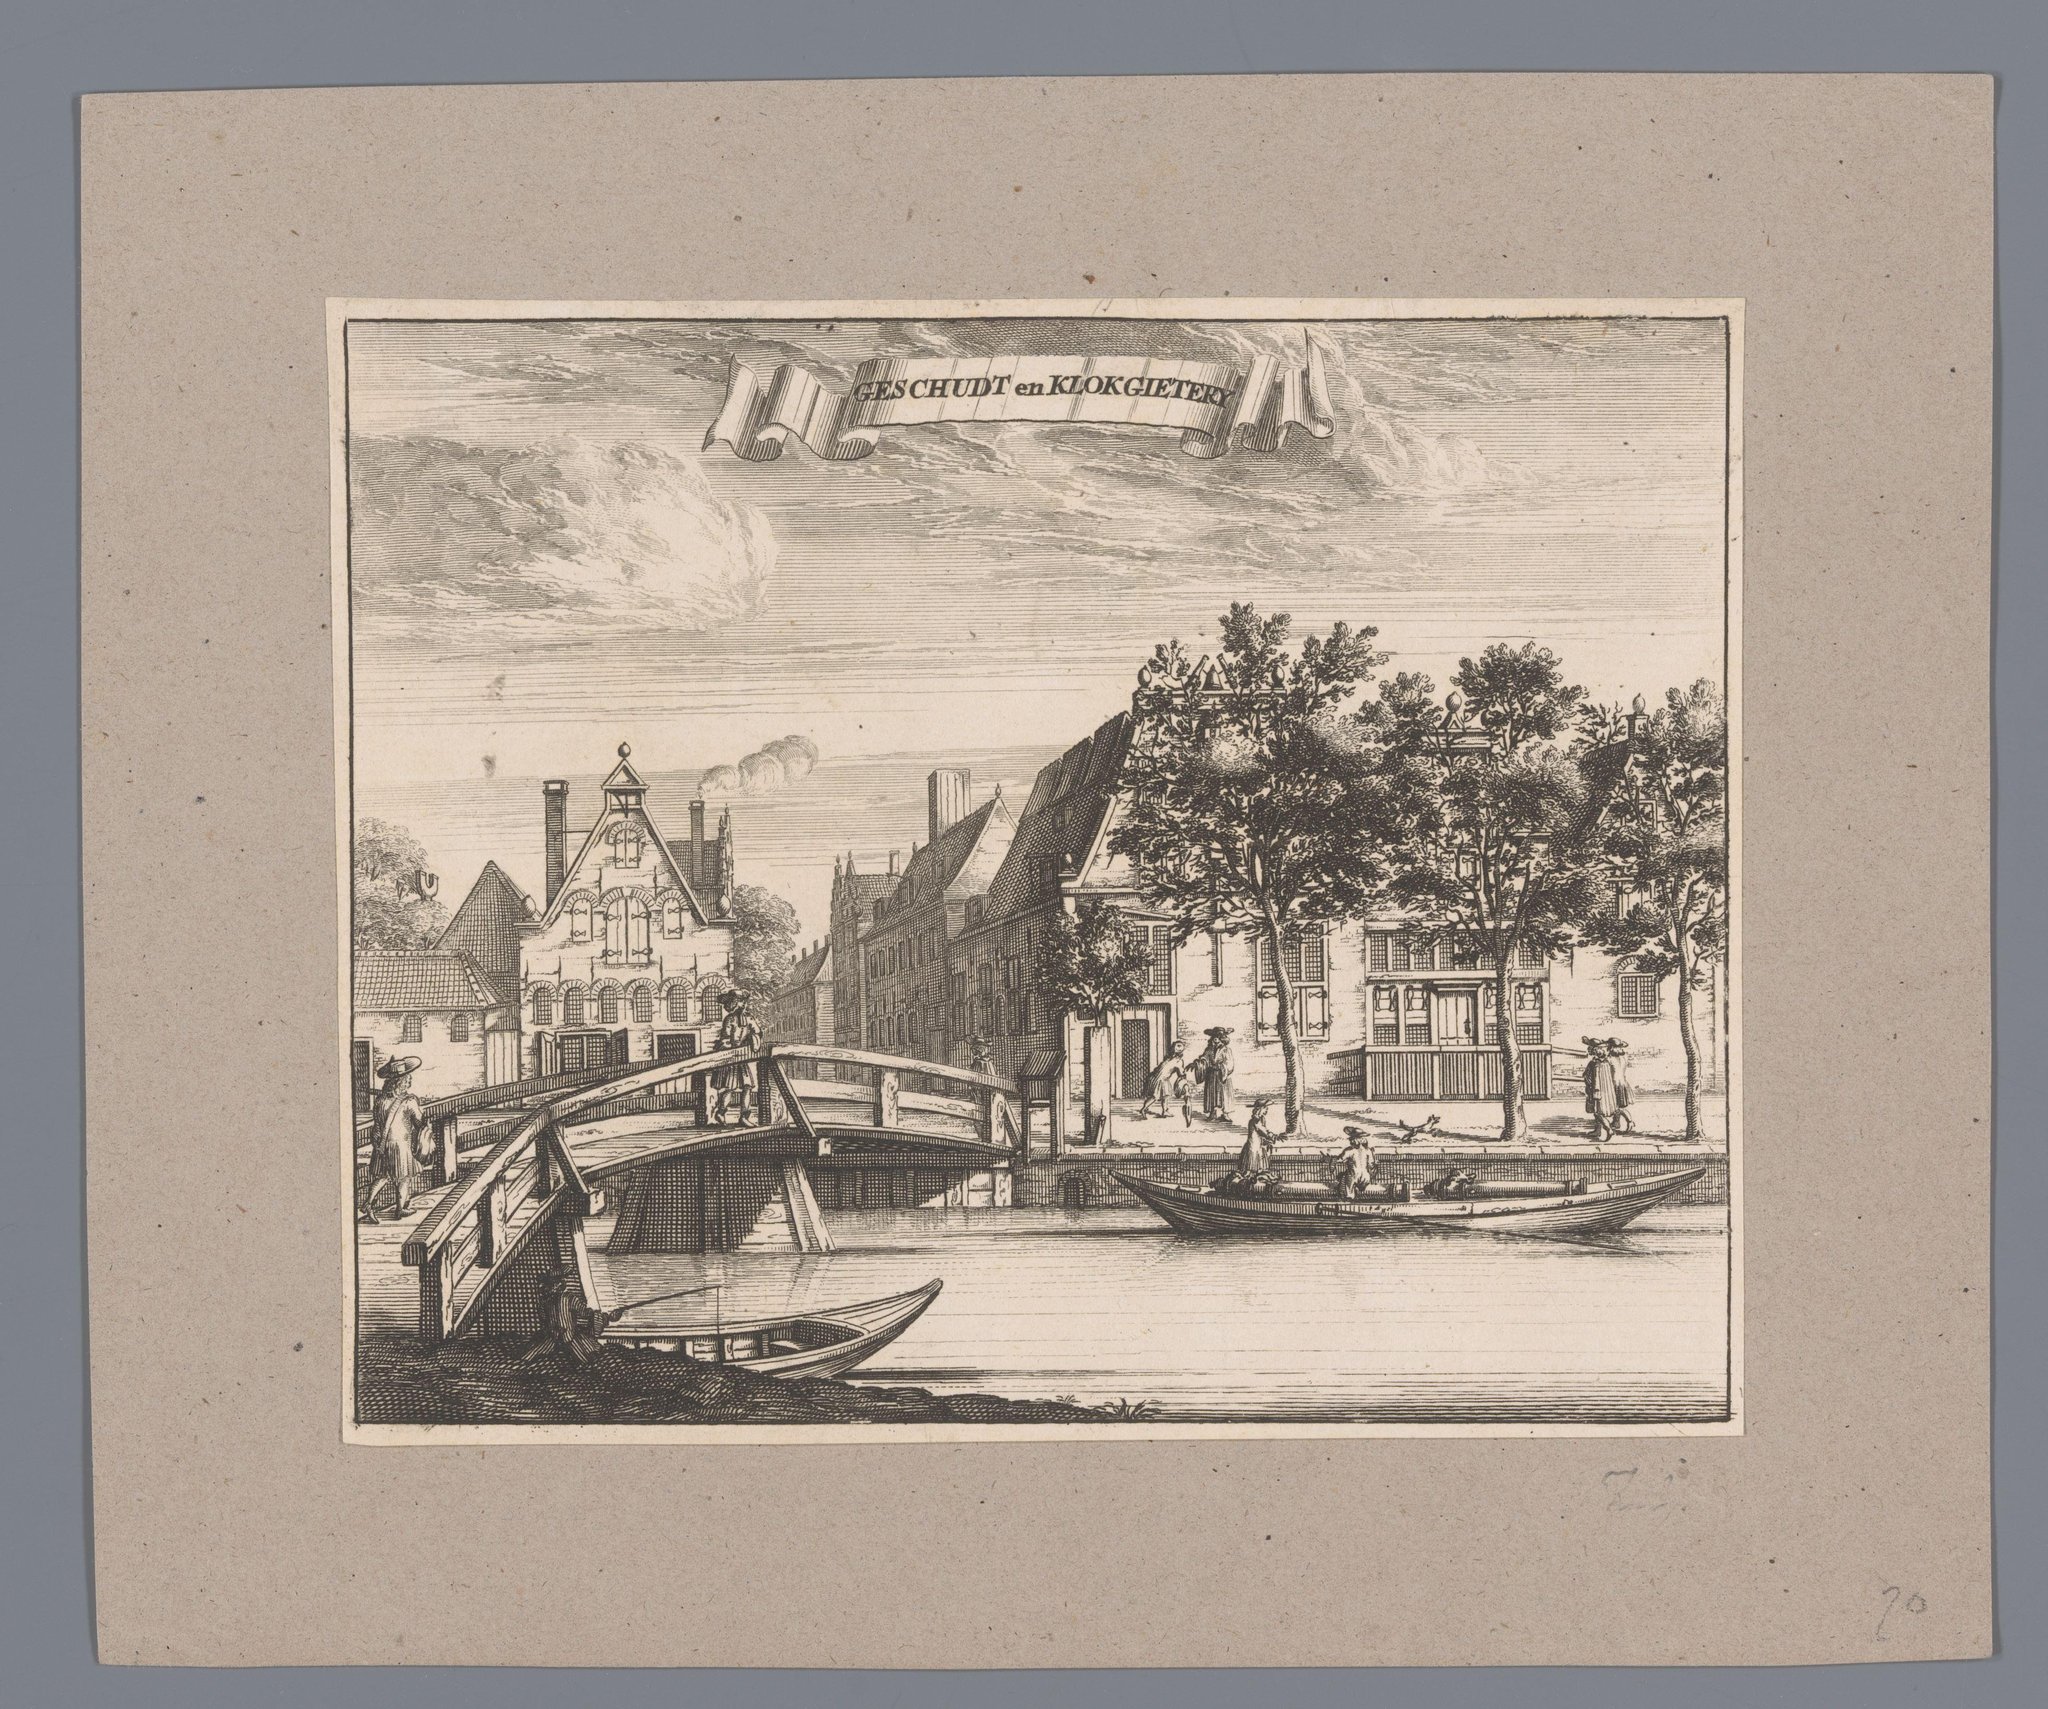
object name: print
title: Geschudt en Klokgietery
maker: Anonymous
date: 1693-1694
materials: paper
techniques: etching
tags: bridge in city across river, canal, etc., amsterdam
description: Prent gebruikt in: Commelin, Caspar. Beschryvinge van Amsterdam, desselfs eerste oorspronk uyt den Huyse (…). 2 dln. Amsterdam: Abraham Wolfgang et al., 1693. Of in: Commelin, Caspar. Beschryvinge van Amsterdam, zynde een naukeurige verhandelinge van desselfs eerste oorspronk uyt (…). 2 dln. Amsterdam: weduwe Aart Dircksz Oossaan, 1694.